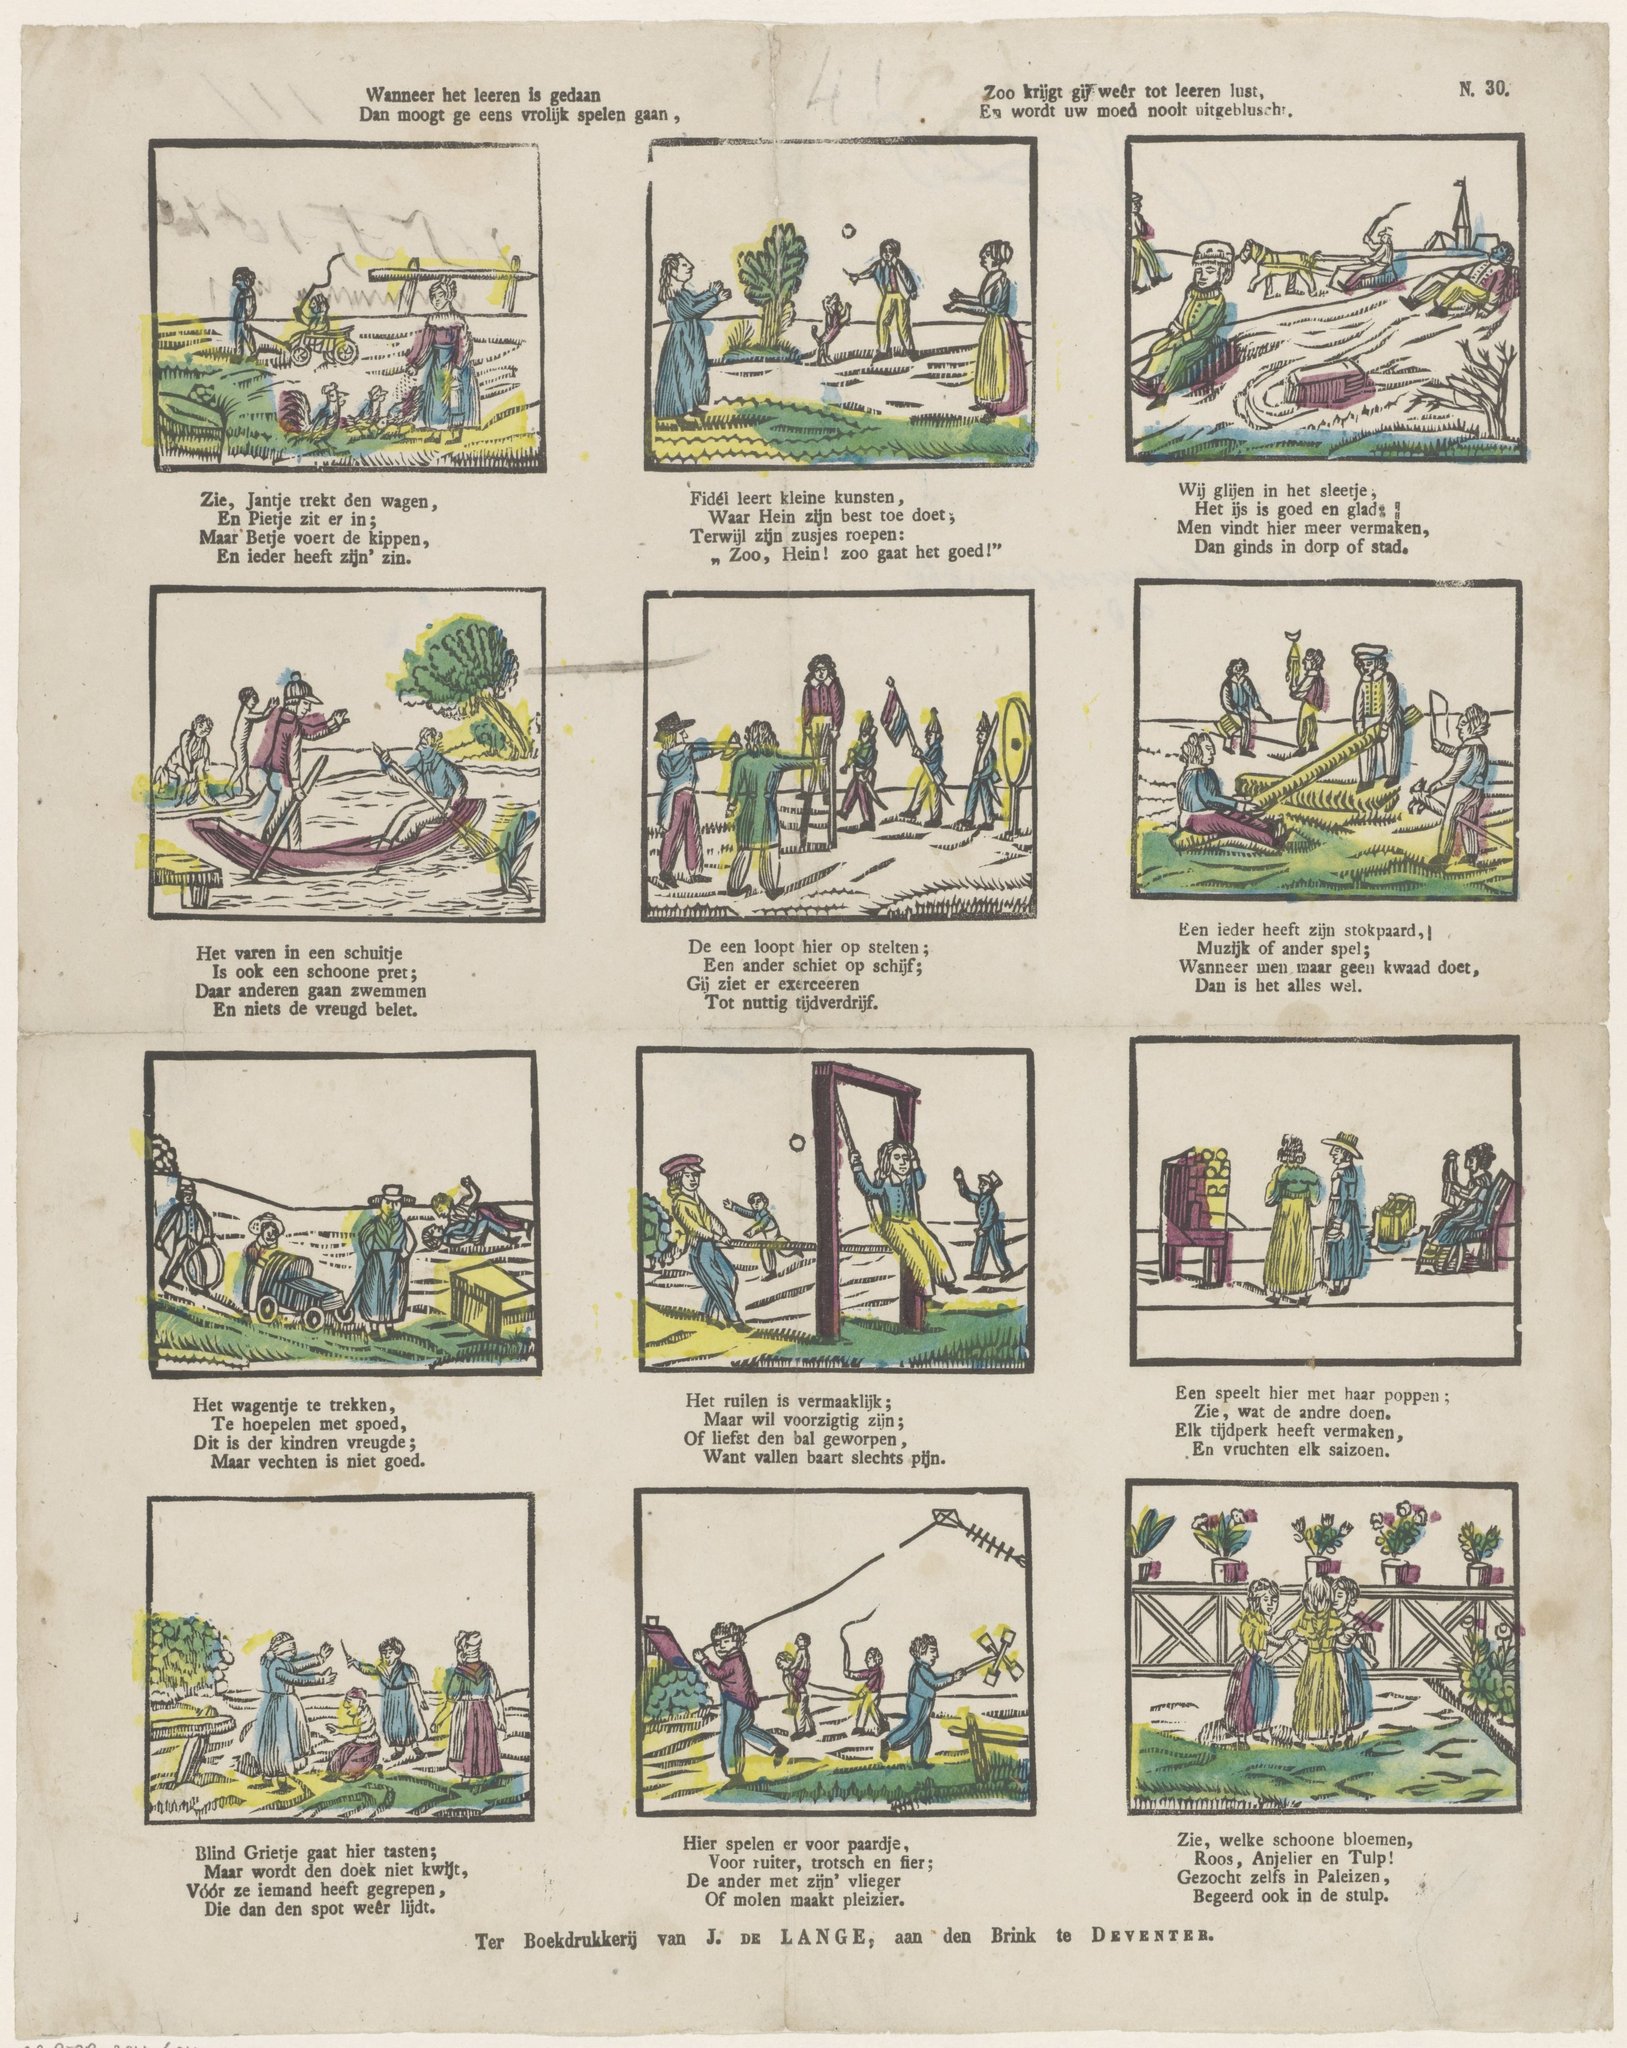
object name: print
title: Wanneer het leeren is gedaan, / Dan moogt ge eens vrolijk spelen gaan; / Zoo krijgt gij weêr tot leeren lust, / En wordt uw moed nooit uitgeblust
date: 1822-1849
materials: paper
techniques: colour, letterpress printing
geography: netherlands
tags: children's games and plays, (flying a) kite, sledge, sleigh (winter sports), (walking on) stilts, seesaw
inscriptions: inscription, collector's mark: Lugt 2760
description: Blad met 12 voorstellingen van kinderspelen, zoals sleeën, op stelten lopen en vliegeren. Onder elke afbeelding een vierregelig vers. Genummerd rechtsboven: N. 30.